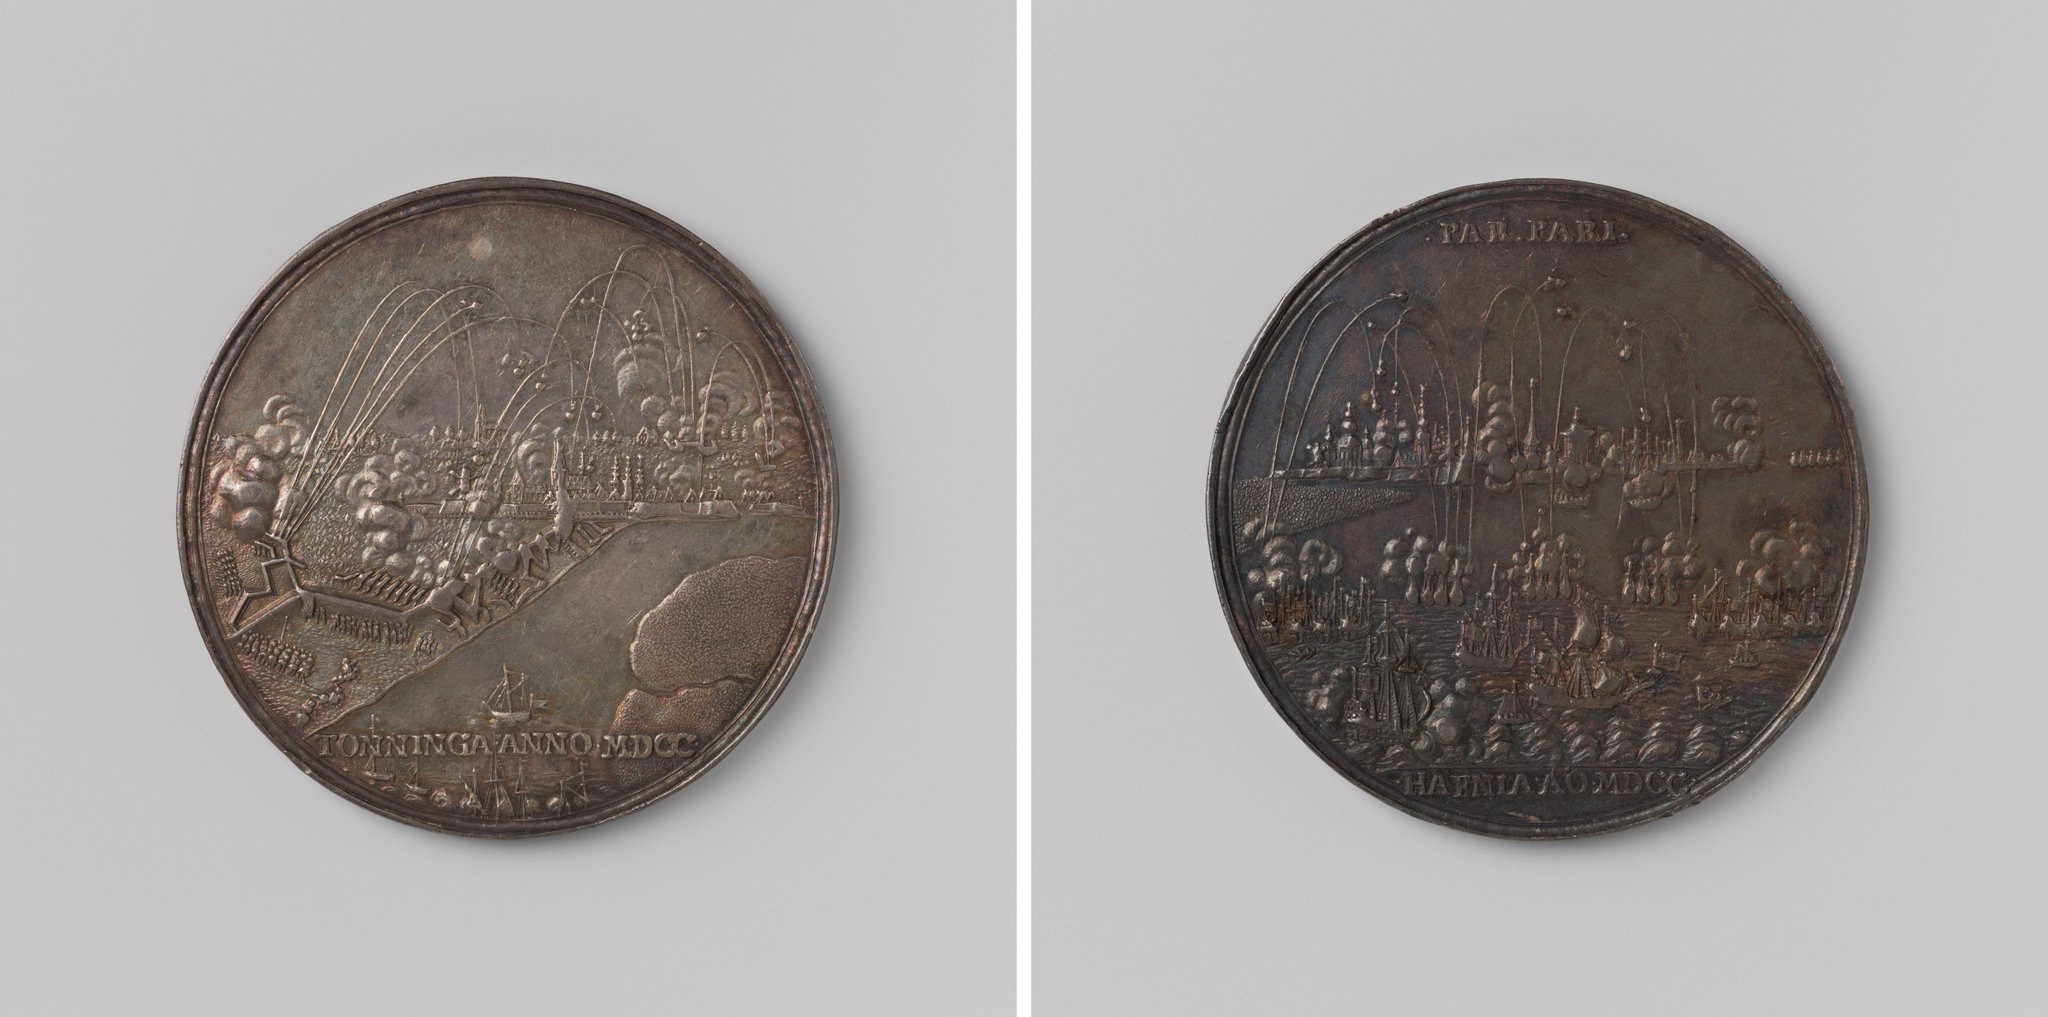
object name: history medal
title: Bombardement van Tonningen en Kopenhagen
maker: Anonymous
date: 1700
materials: silver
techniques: striking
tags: copenhagen (city)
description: Zilveren penning. Voorzijde: stad tijdens beschieting boven opschrift. Keerzijde: stad tijdens beschieting door vloot tussen opschriften